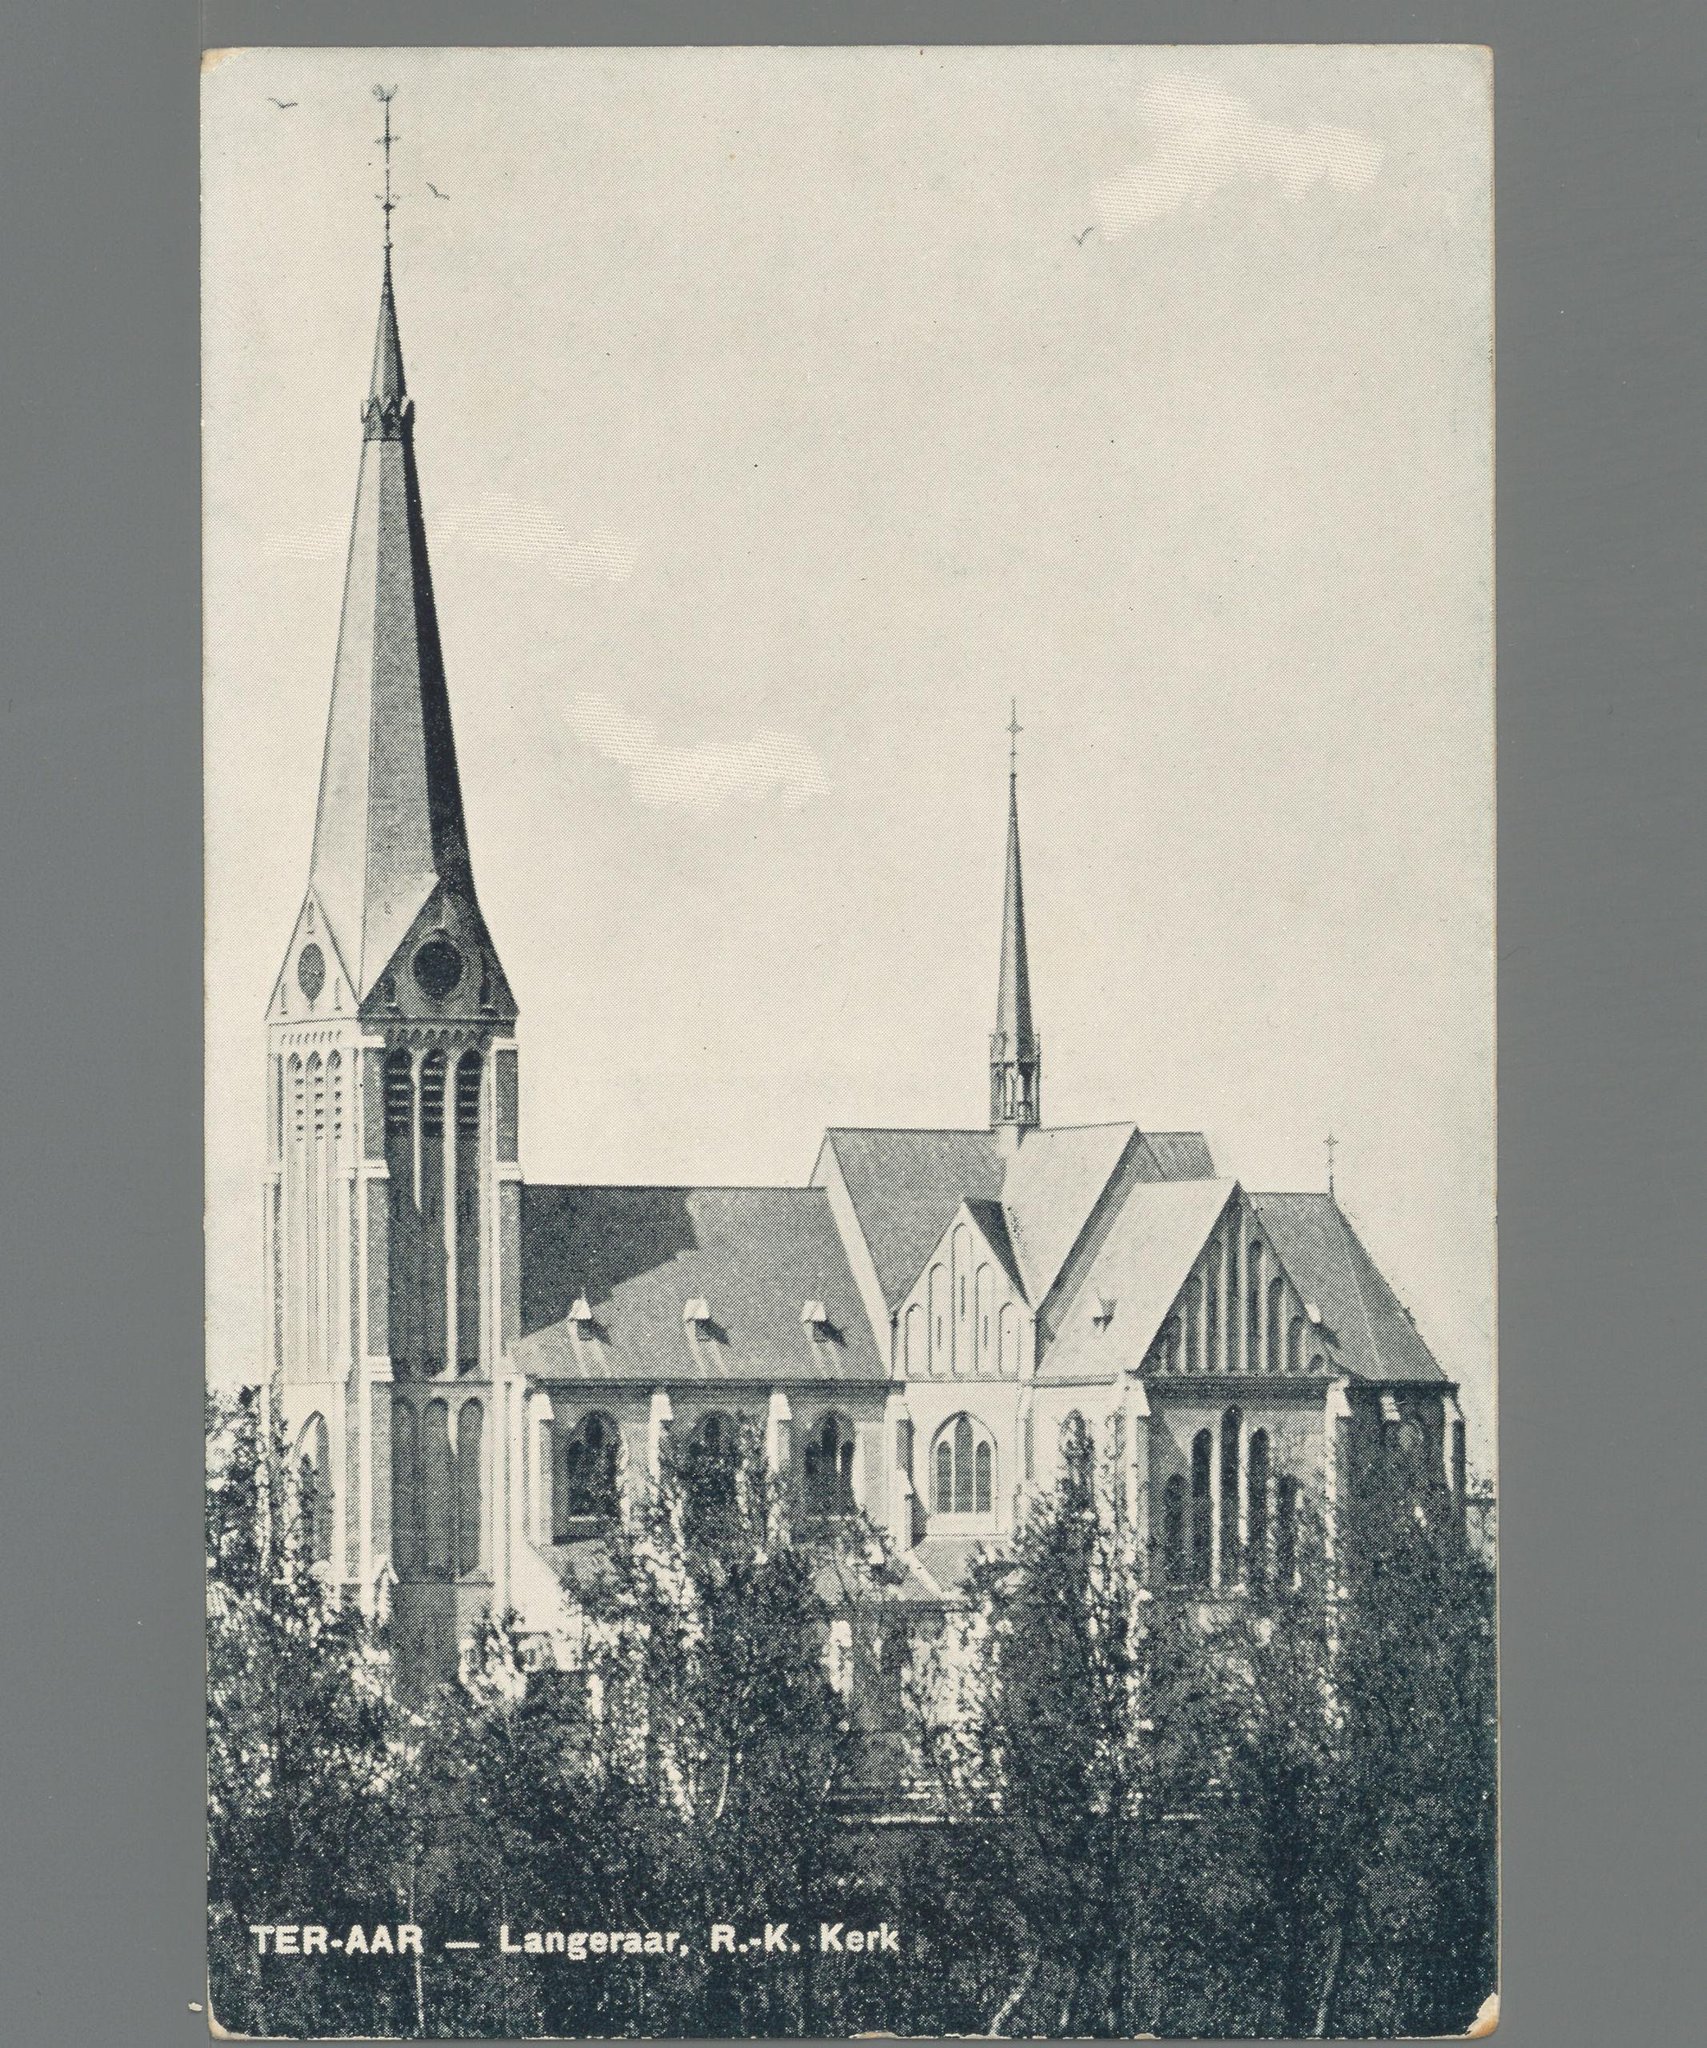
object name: photomechanical print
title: Ter-Aar - Langeraar, R.-K. Kerk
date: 1905-1930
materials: cardboard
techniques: autotype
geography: ter aar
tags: church (exterior)